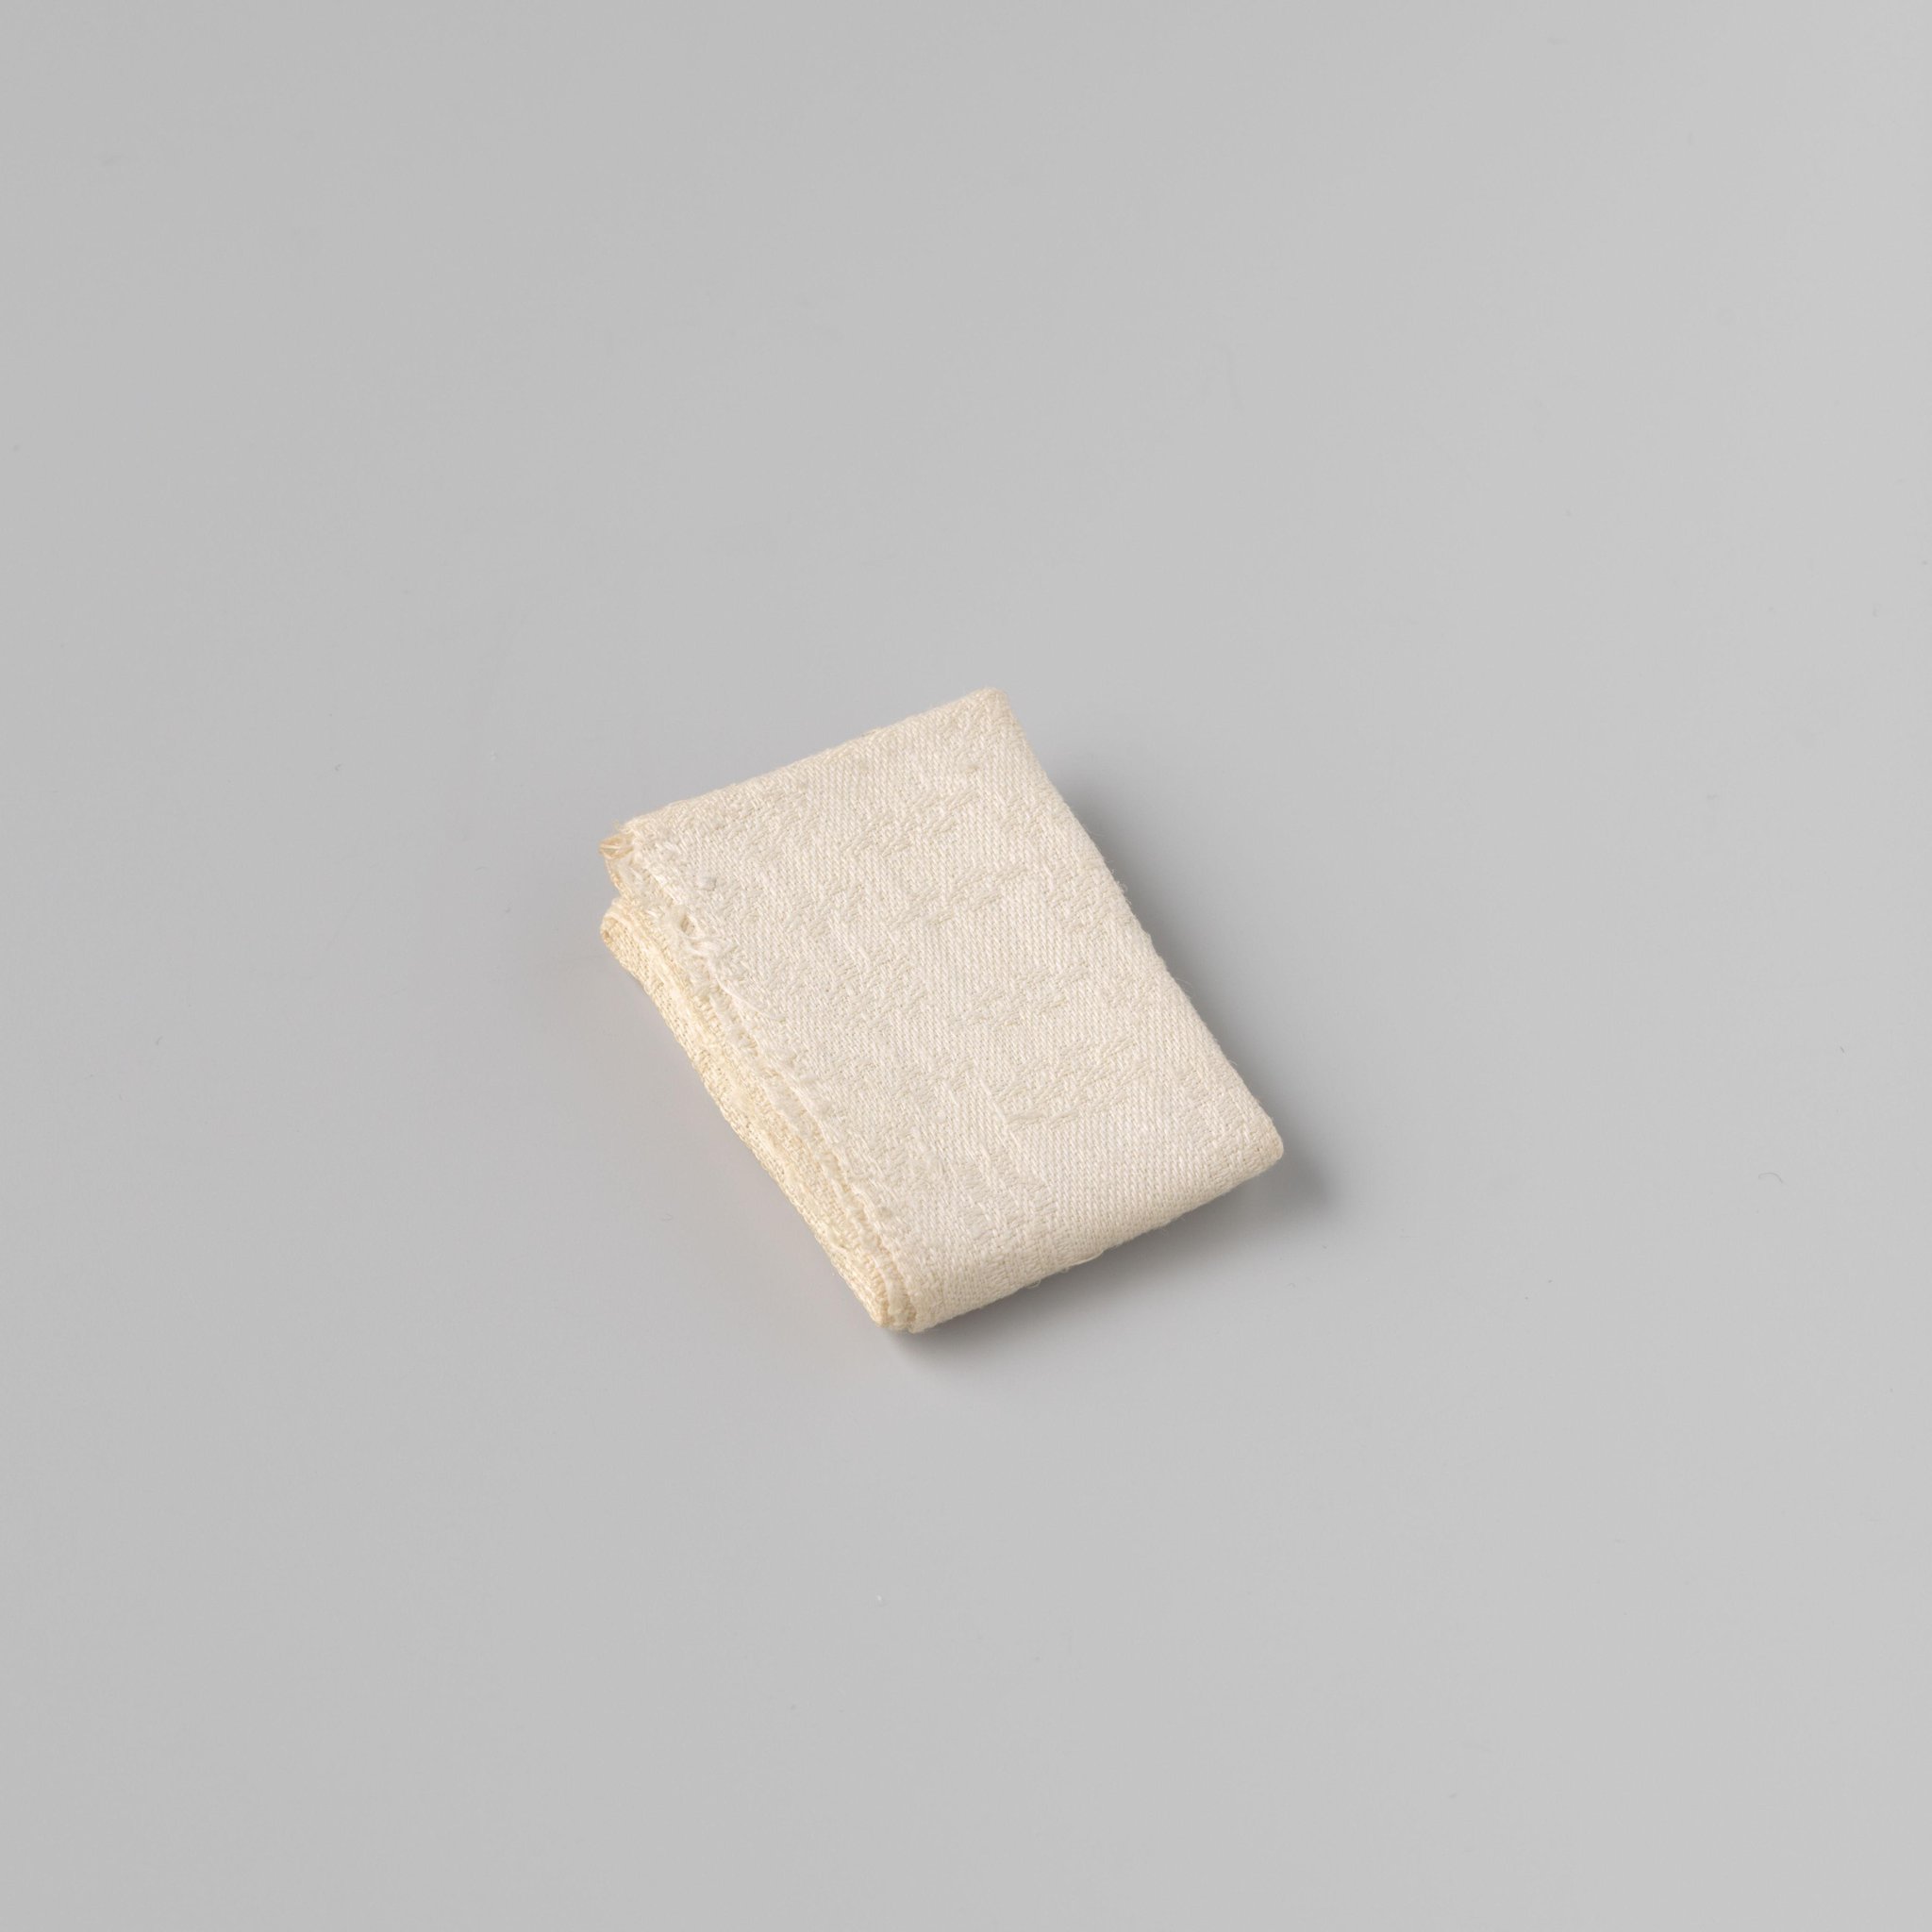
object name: dwaal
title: Linnen servet van damastweefsel met pellenpatroon (motief III), geen zomen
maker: Anonymous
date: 1690-1710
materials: linen